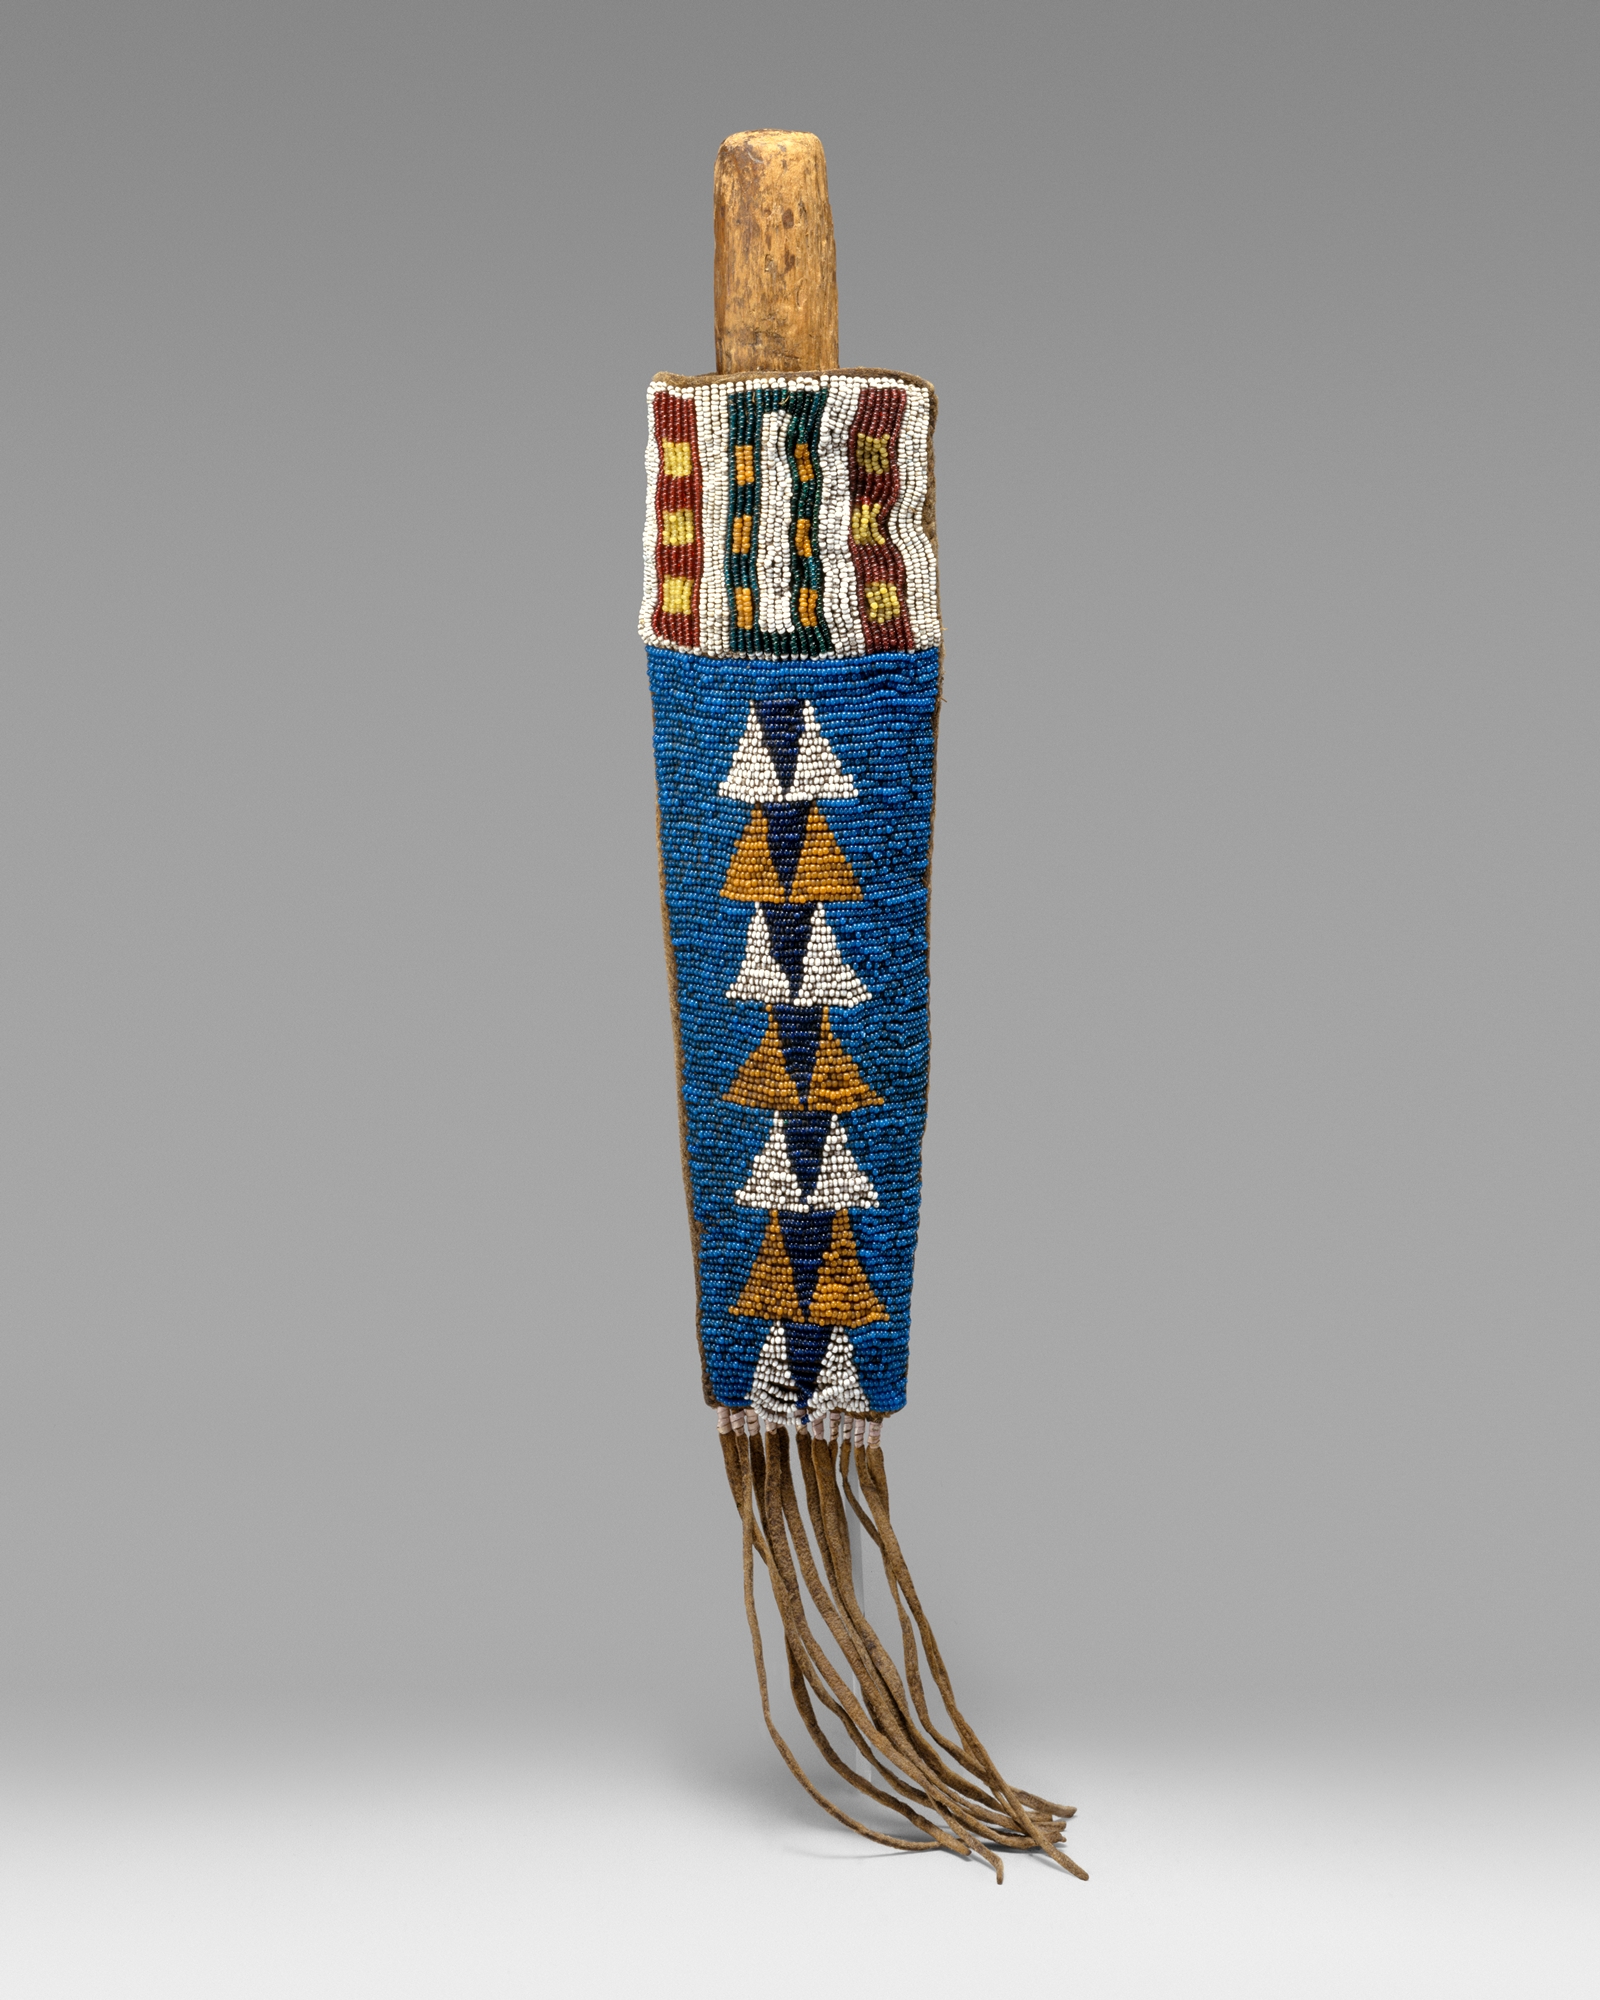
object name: knife and case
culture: assiniboine or gros ventre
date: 1870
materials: glass, metal, skin, wood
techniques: tanning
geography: united states